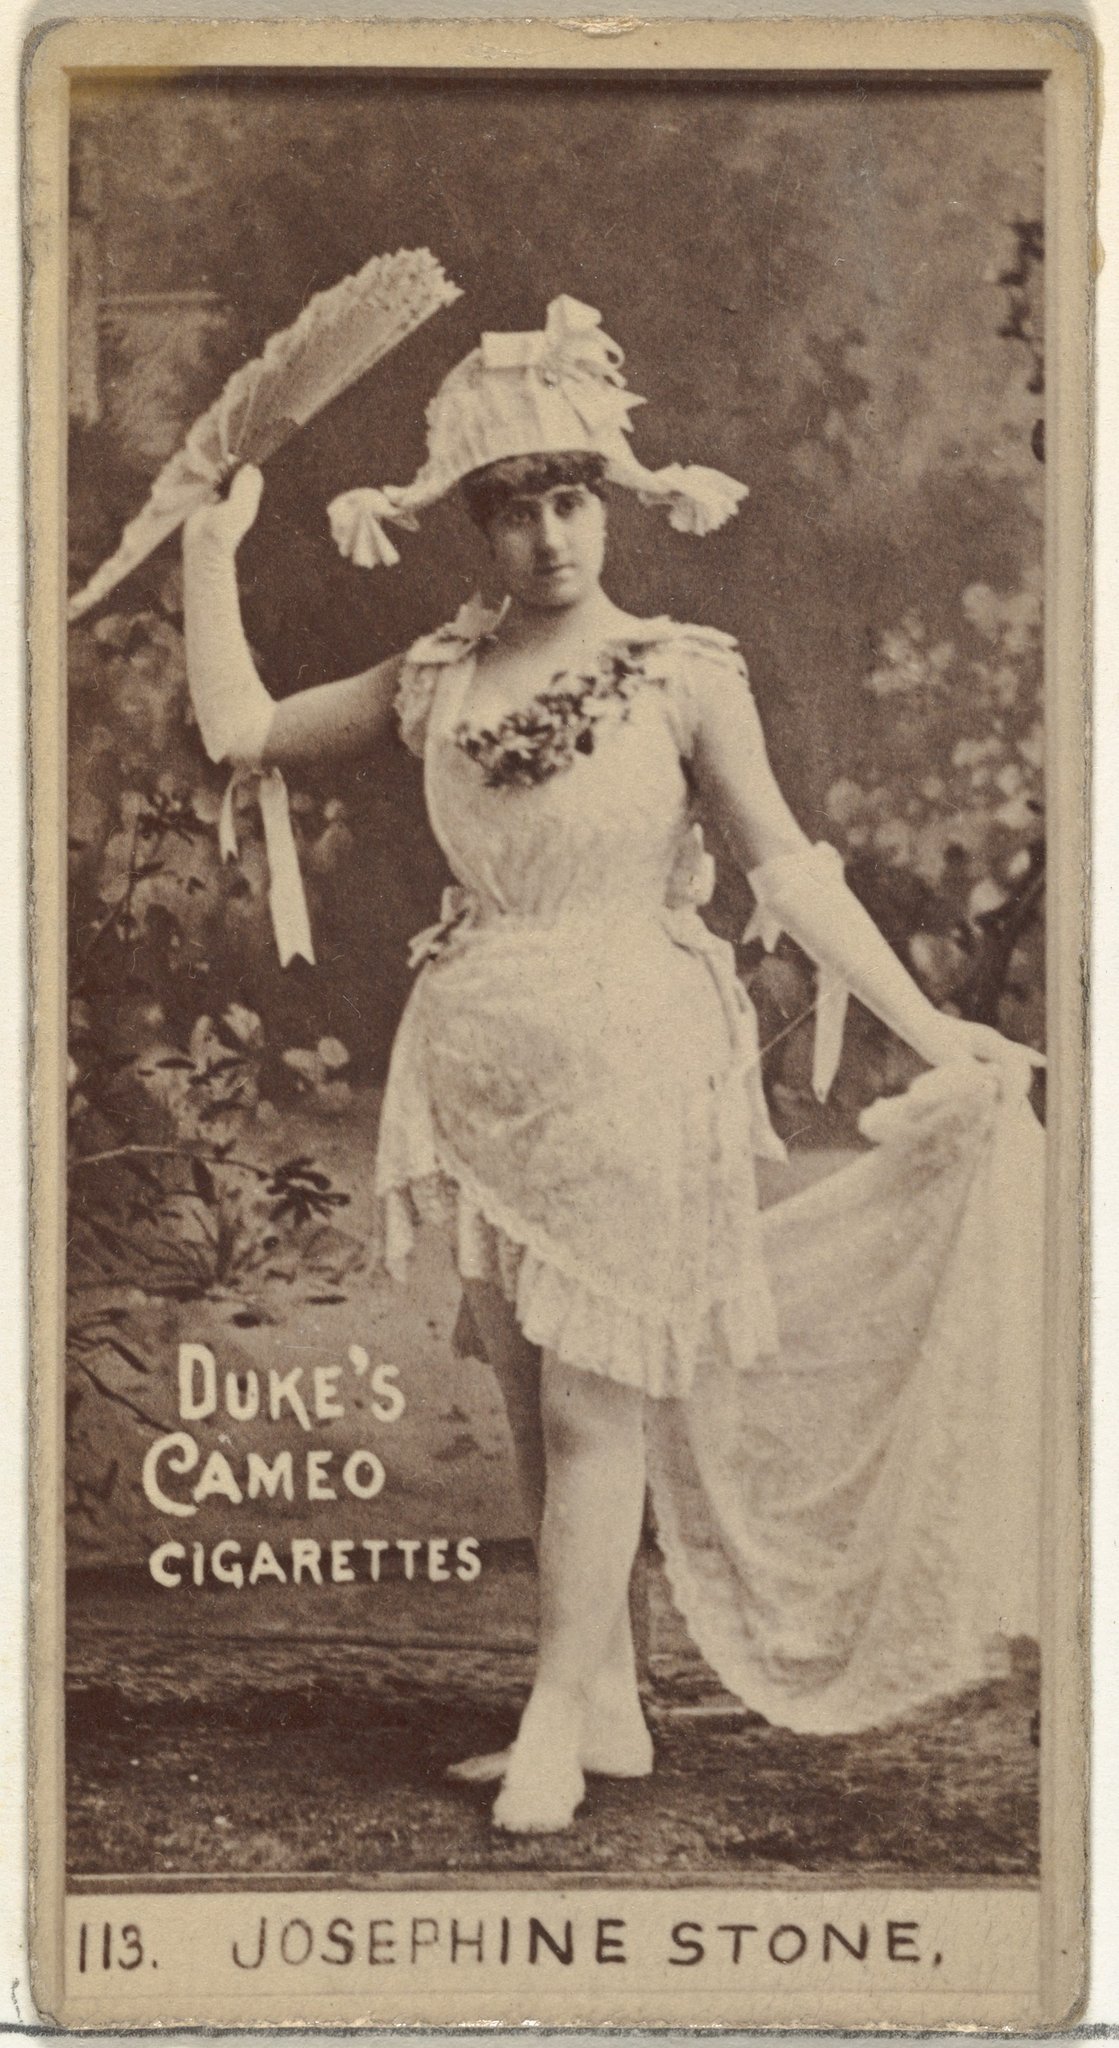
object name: photograph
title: Card Number 113, Josephine Stone, from the Actors and Actresses series (N145-4) issued by Duke Sons & Co. to promote Cameo Cigarettes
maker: w. duke, sons & co.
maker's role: publisher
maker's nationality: american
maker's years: 1870-1920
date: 1880-1889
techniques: albumen silver print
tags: fans,portraits,women,actresses